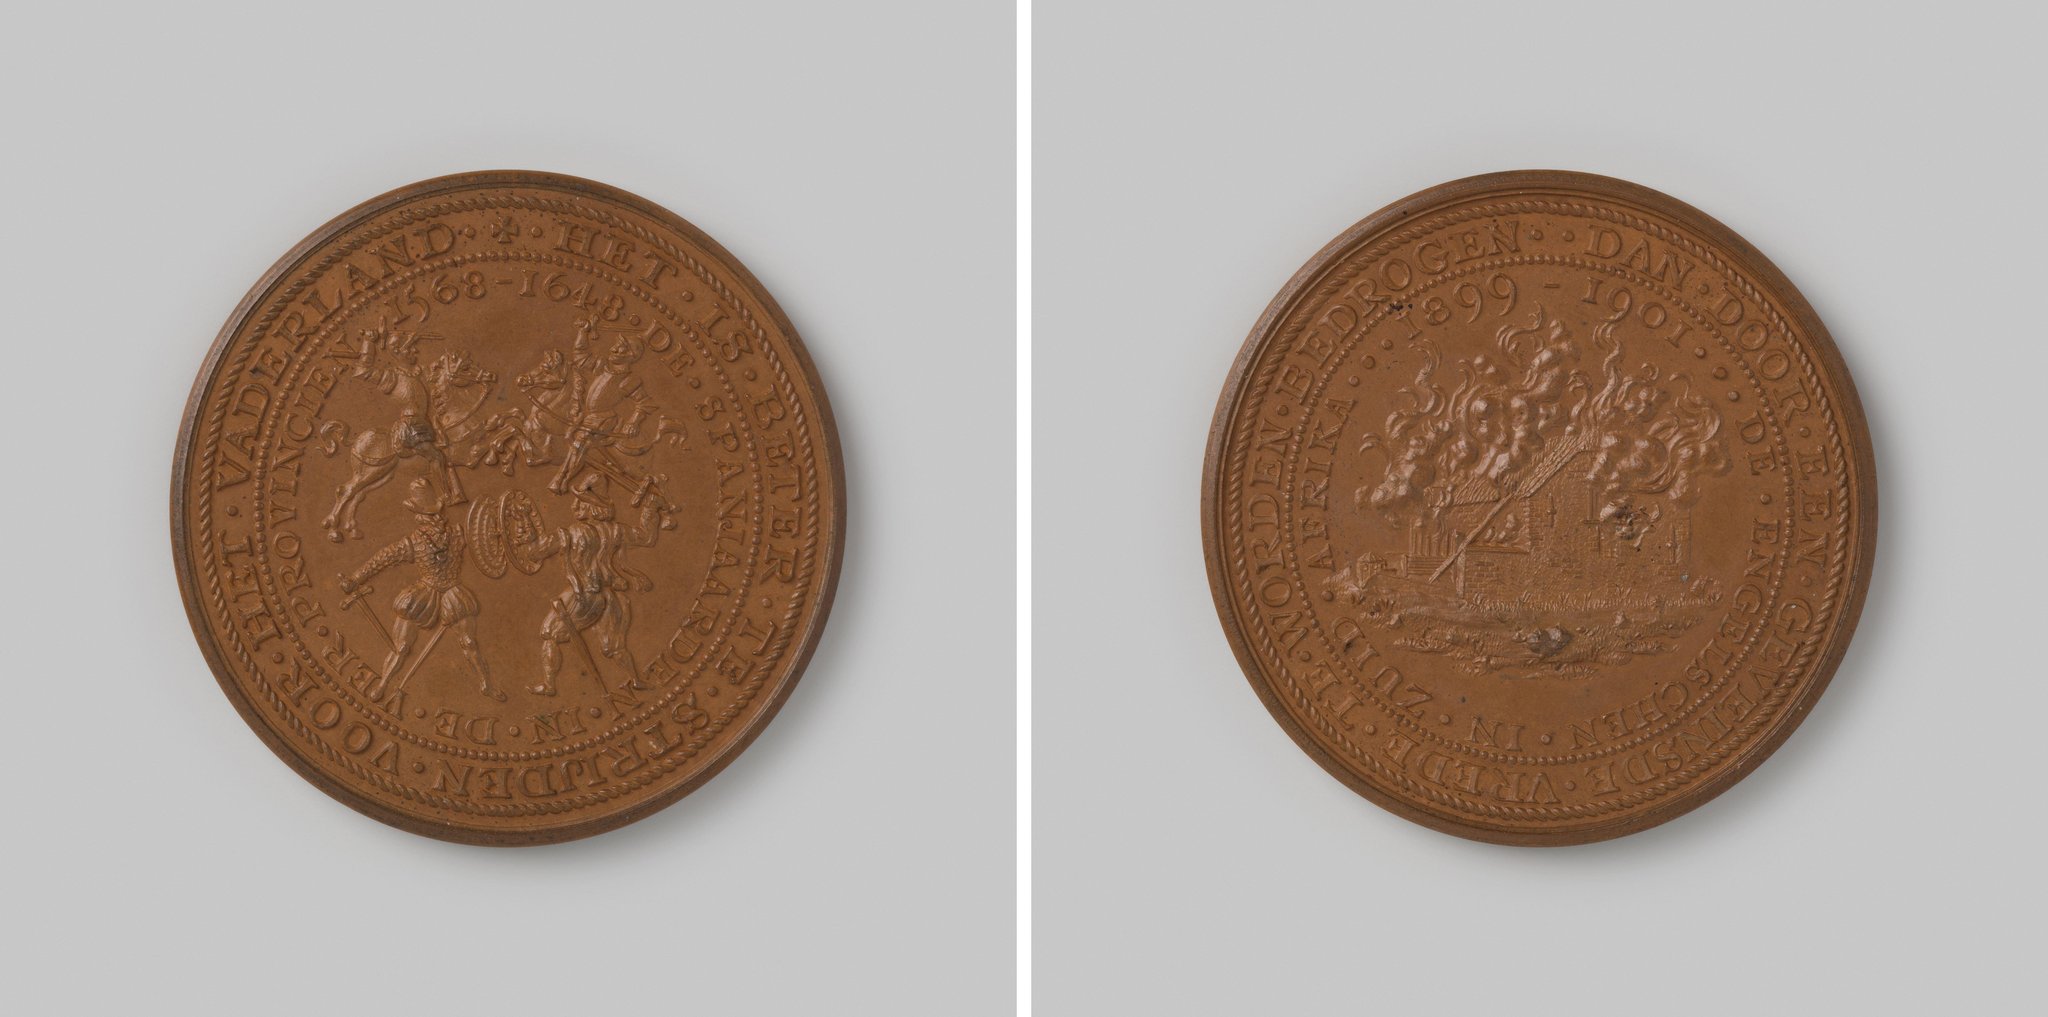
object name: history medal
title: Waarschuwing voor de Boeren in de Tweede Transvaalse Oorlog 1901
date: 1901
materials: bronze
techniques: striking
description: Bronzen penning, naar voorbeeld van een rekenpenning, op de voorzijde vier strijdende soldaten met dubbel omschrift, op de keerzijde een brandend huis met dubbel omschrift.